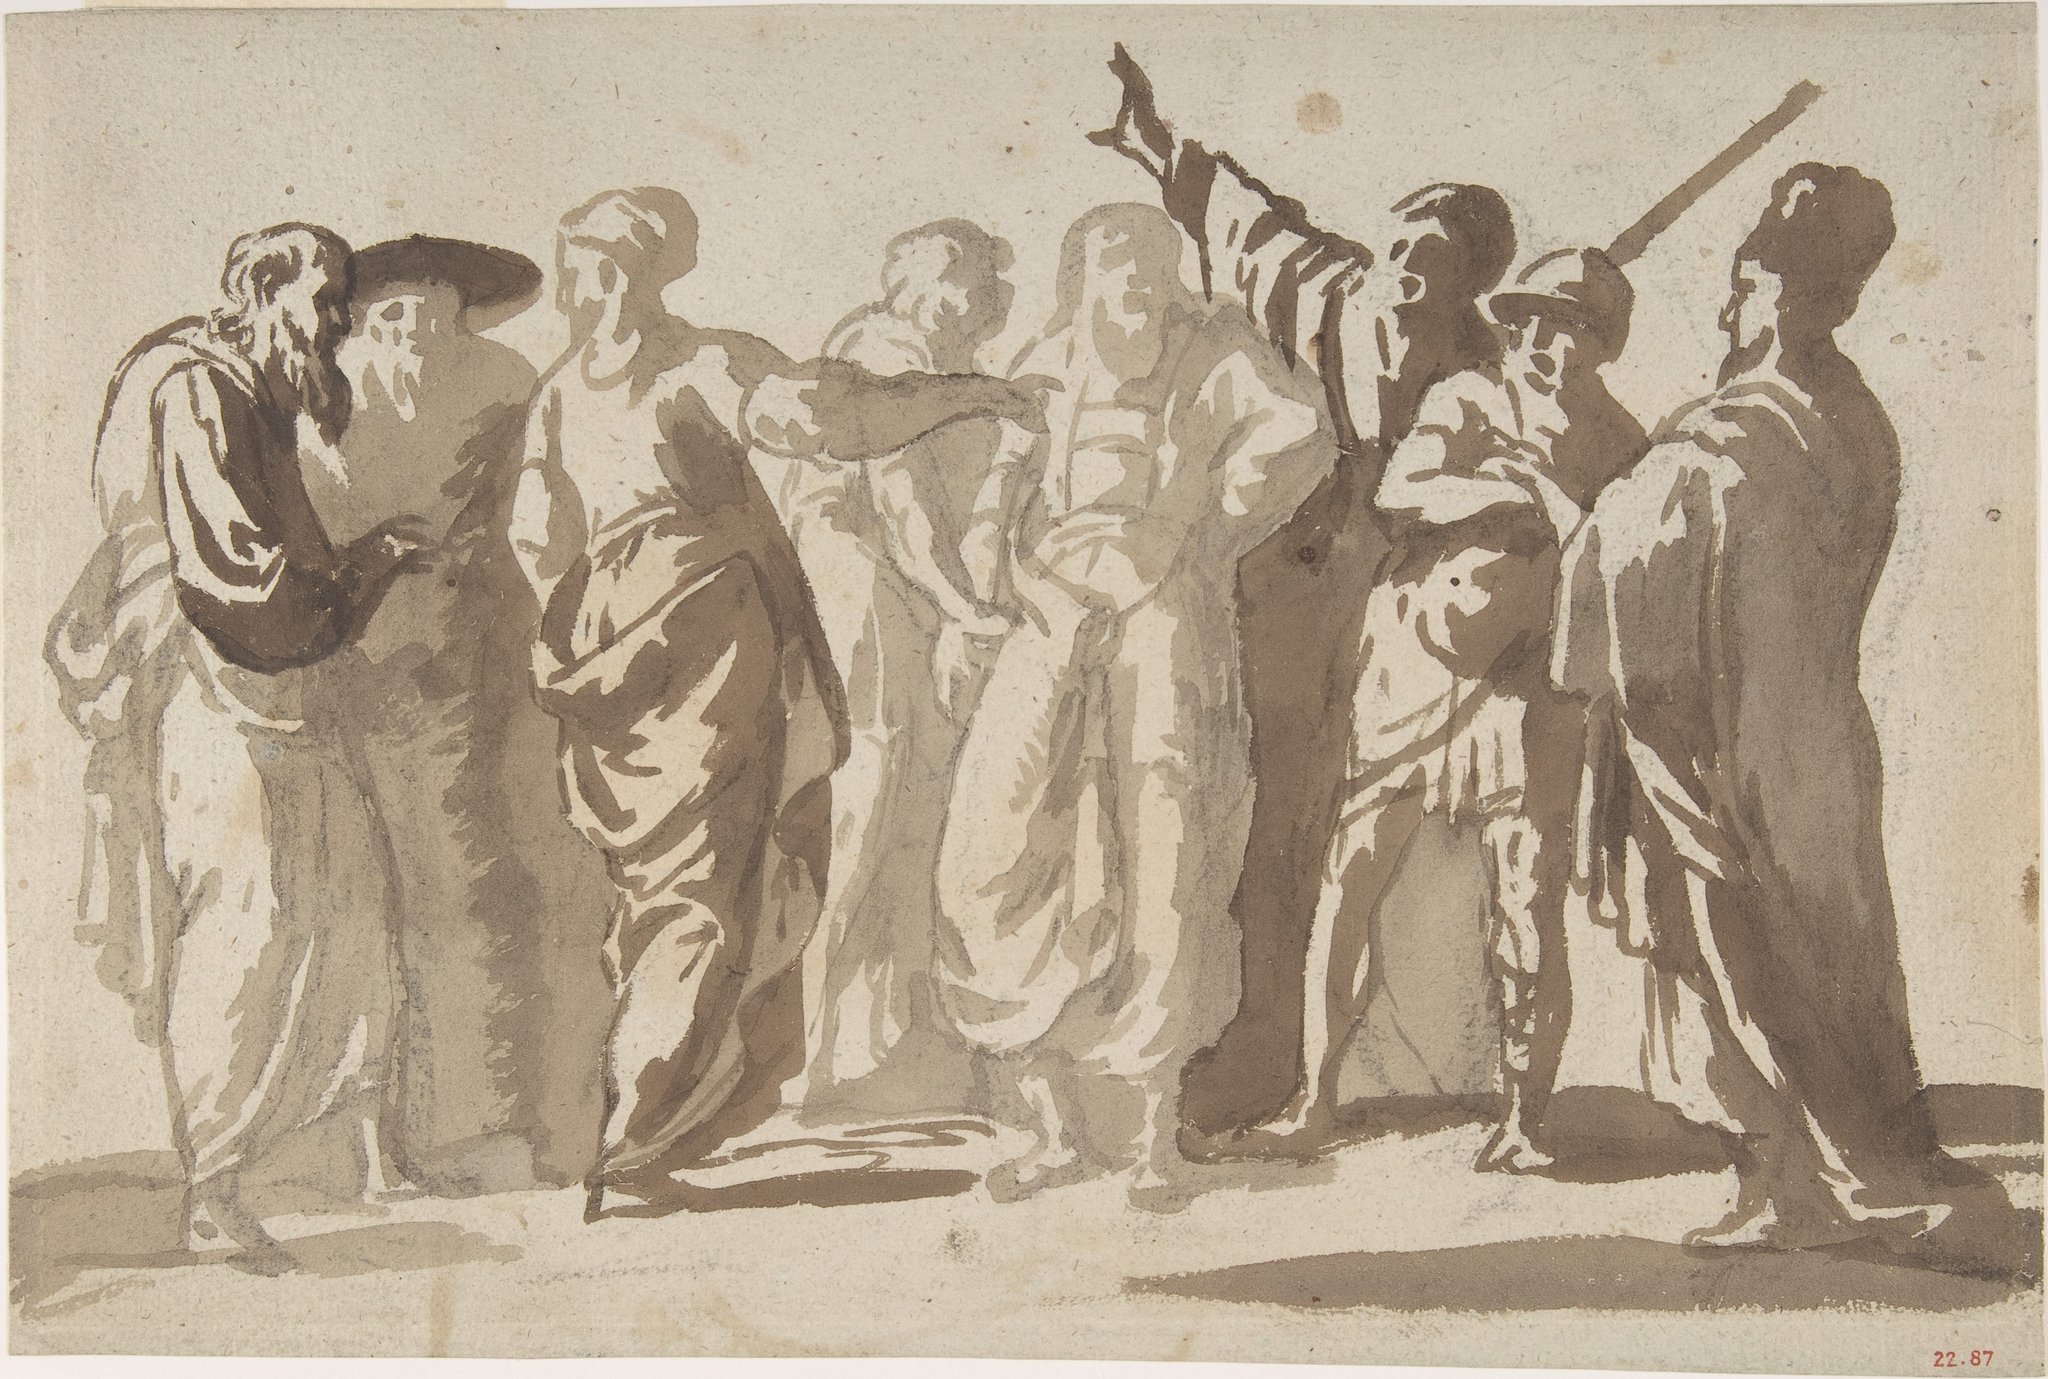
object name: drawing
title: Group of Men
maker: master of the large figure brush drawings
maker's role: artist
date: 1601-1700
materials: chalk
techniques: brush, wash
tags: men